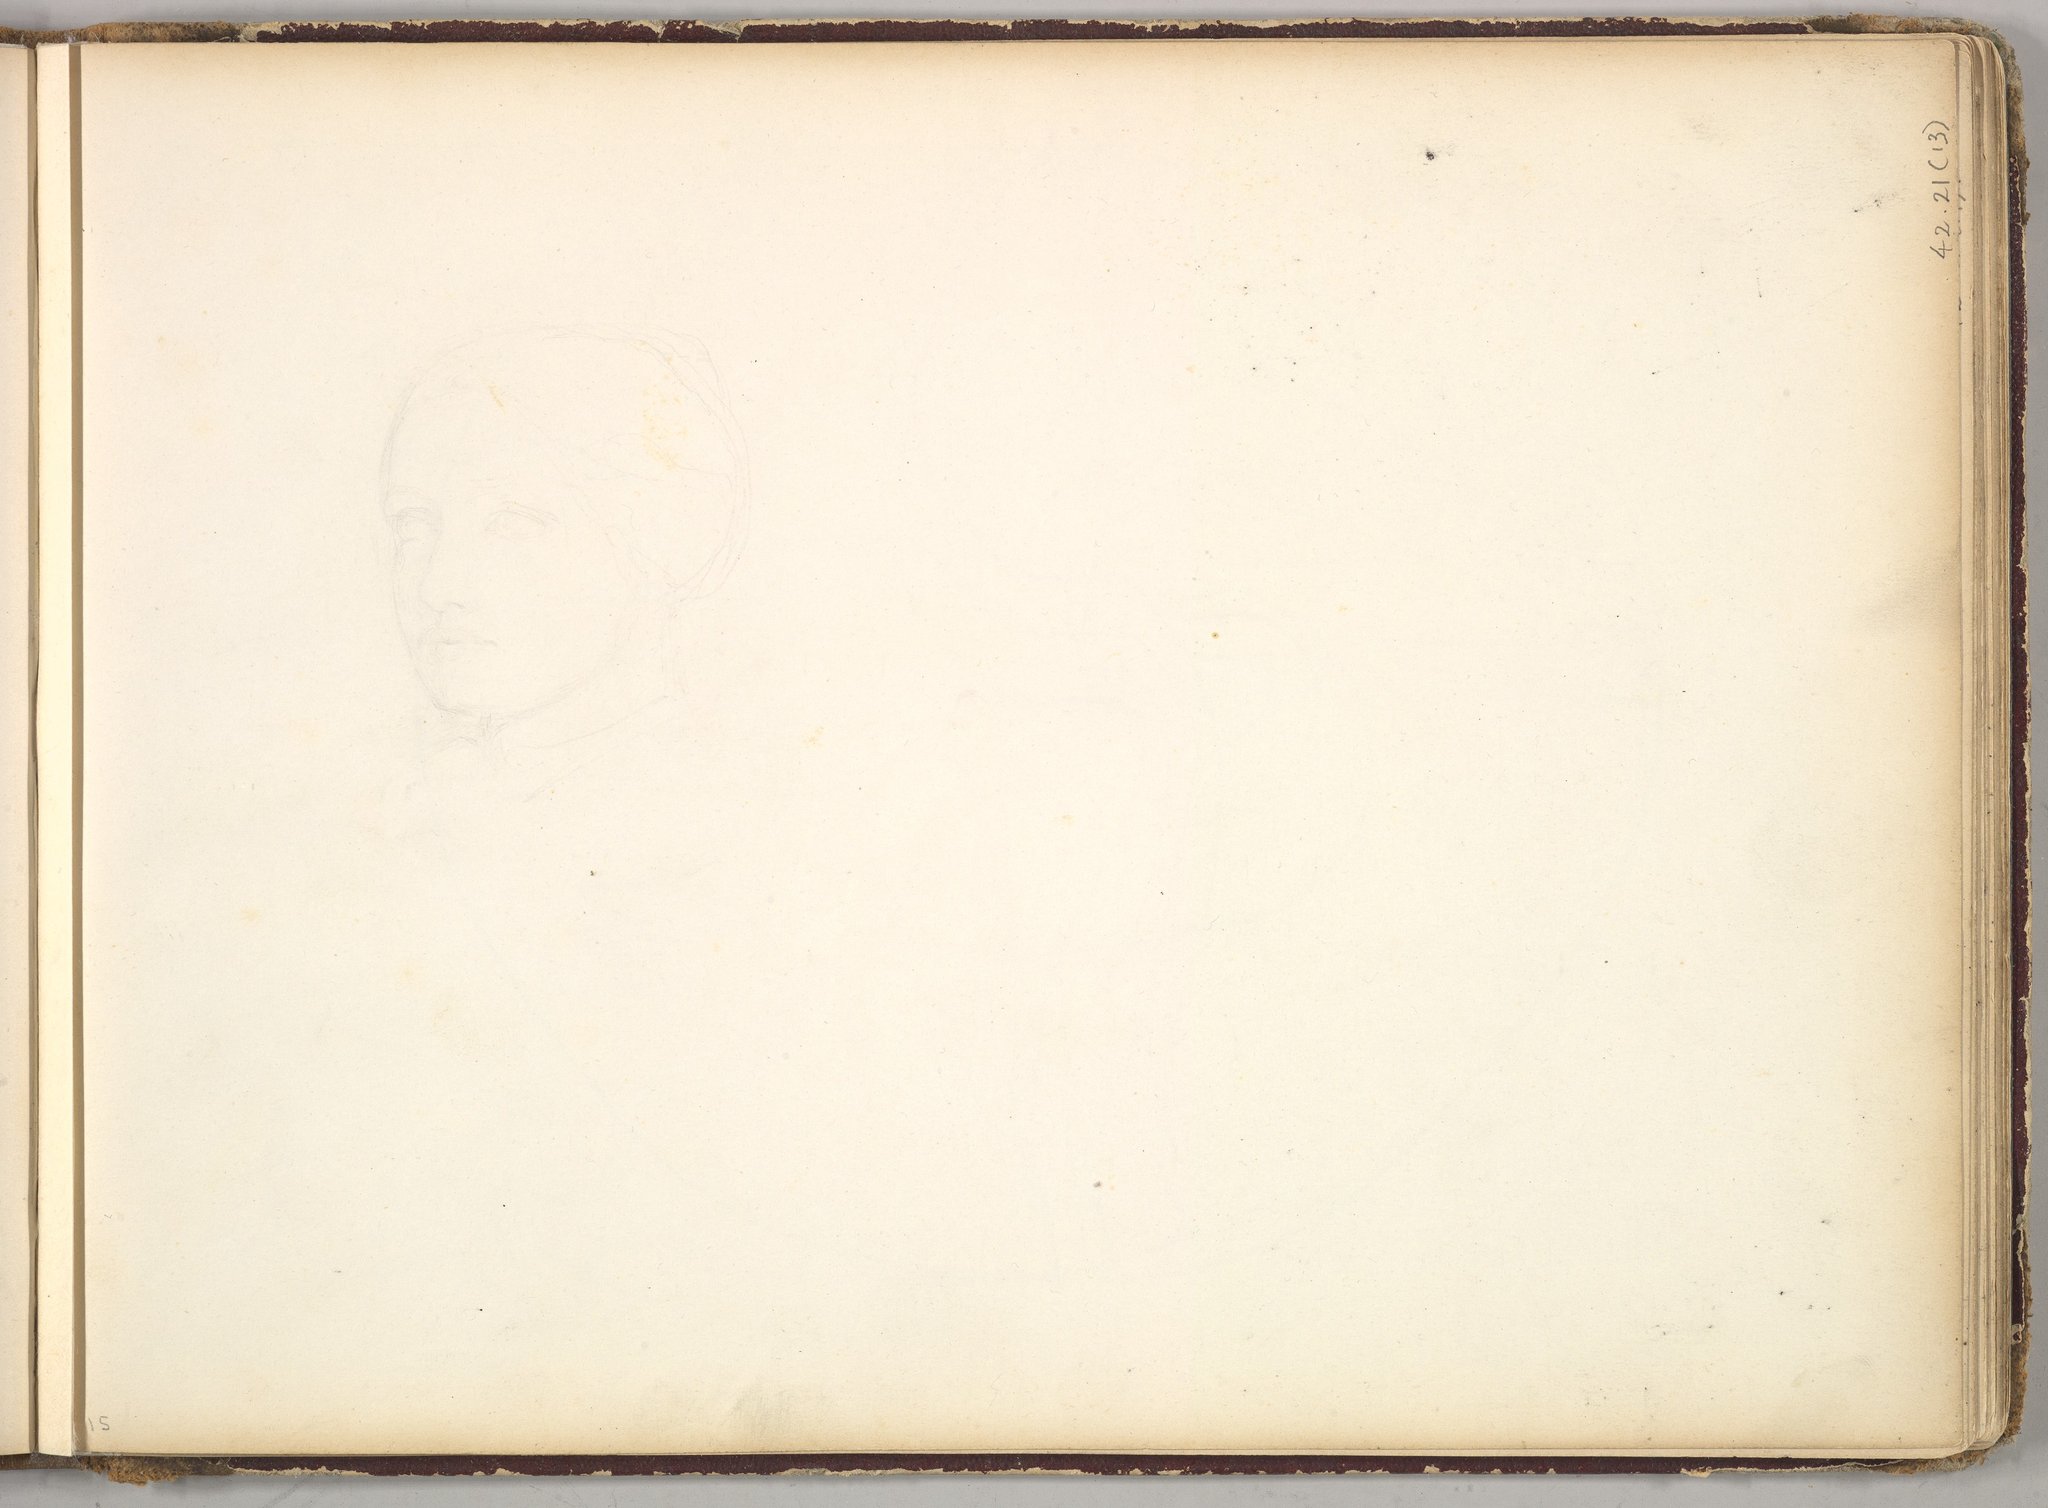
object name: drawing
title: Head of a Boy or Youth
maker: frederic, lord leighton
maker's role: artist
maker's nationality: british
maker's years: 1830-1896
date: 1849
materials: graphite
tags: heads,boys